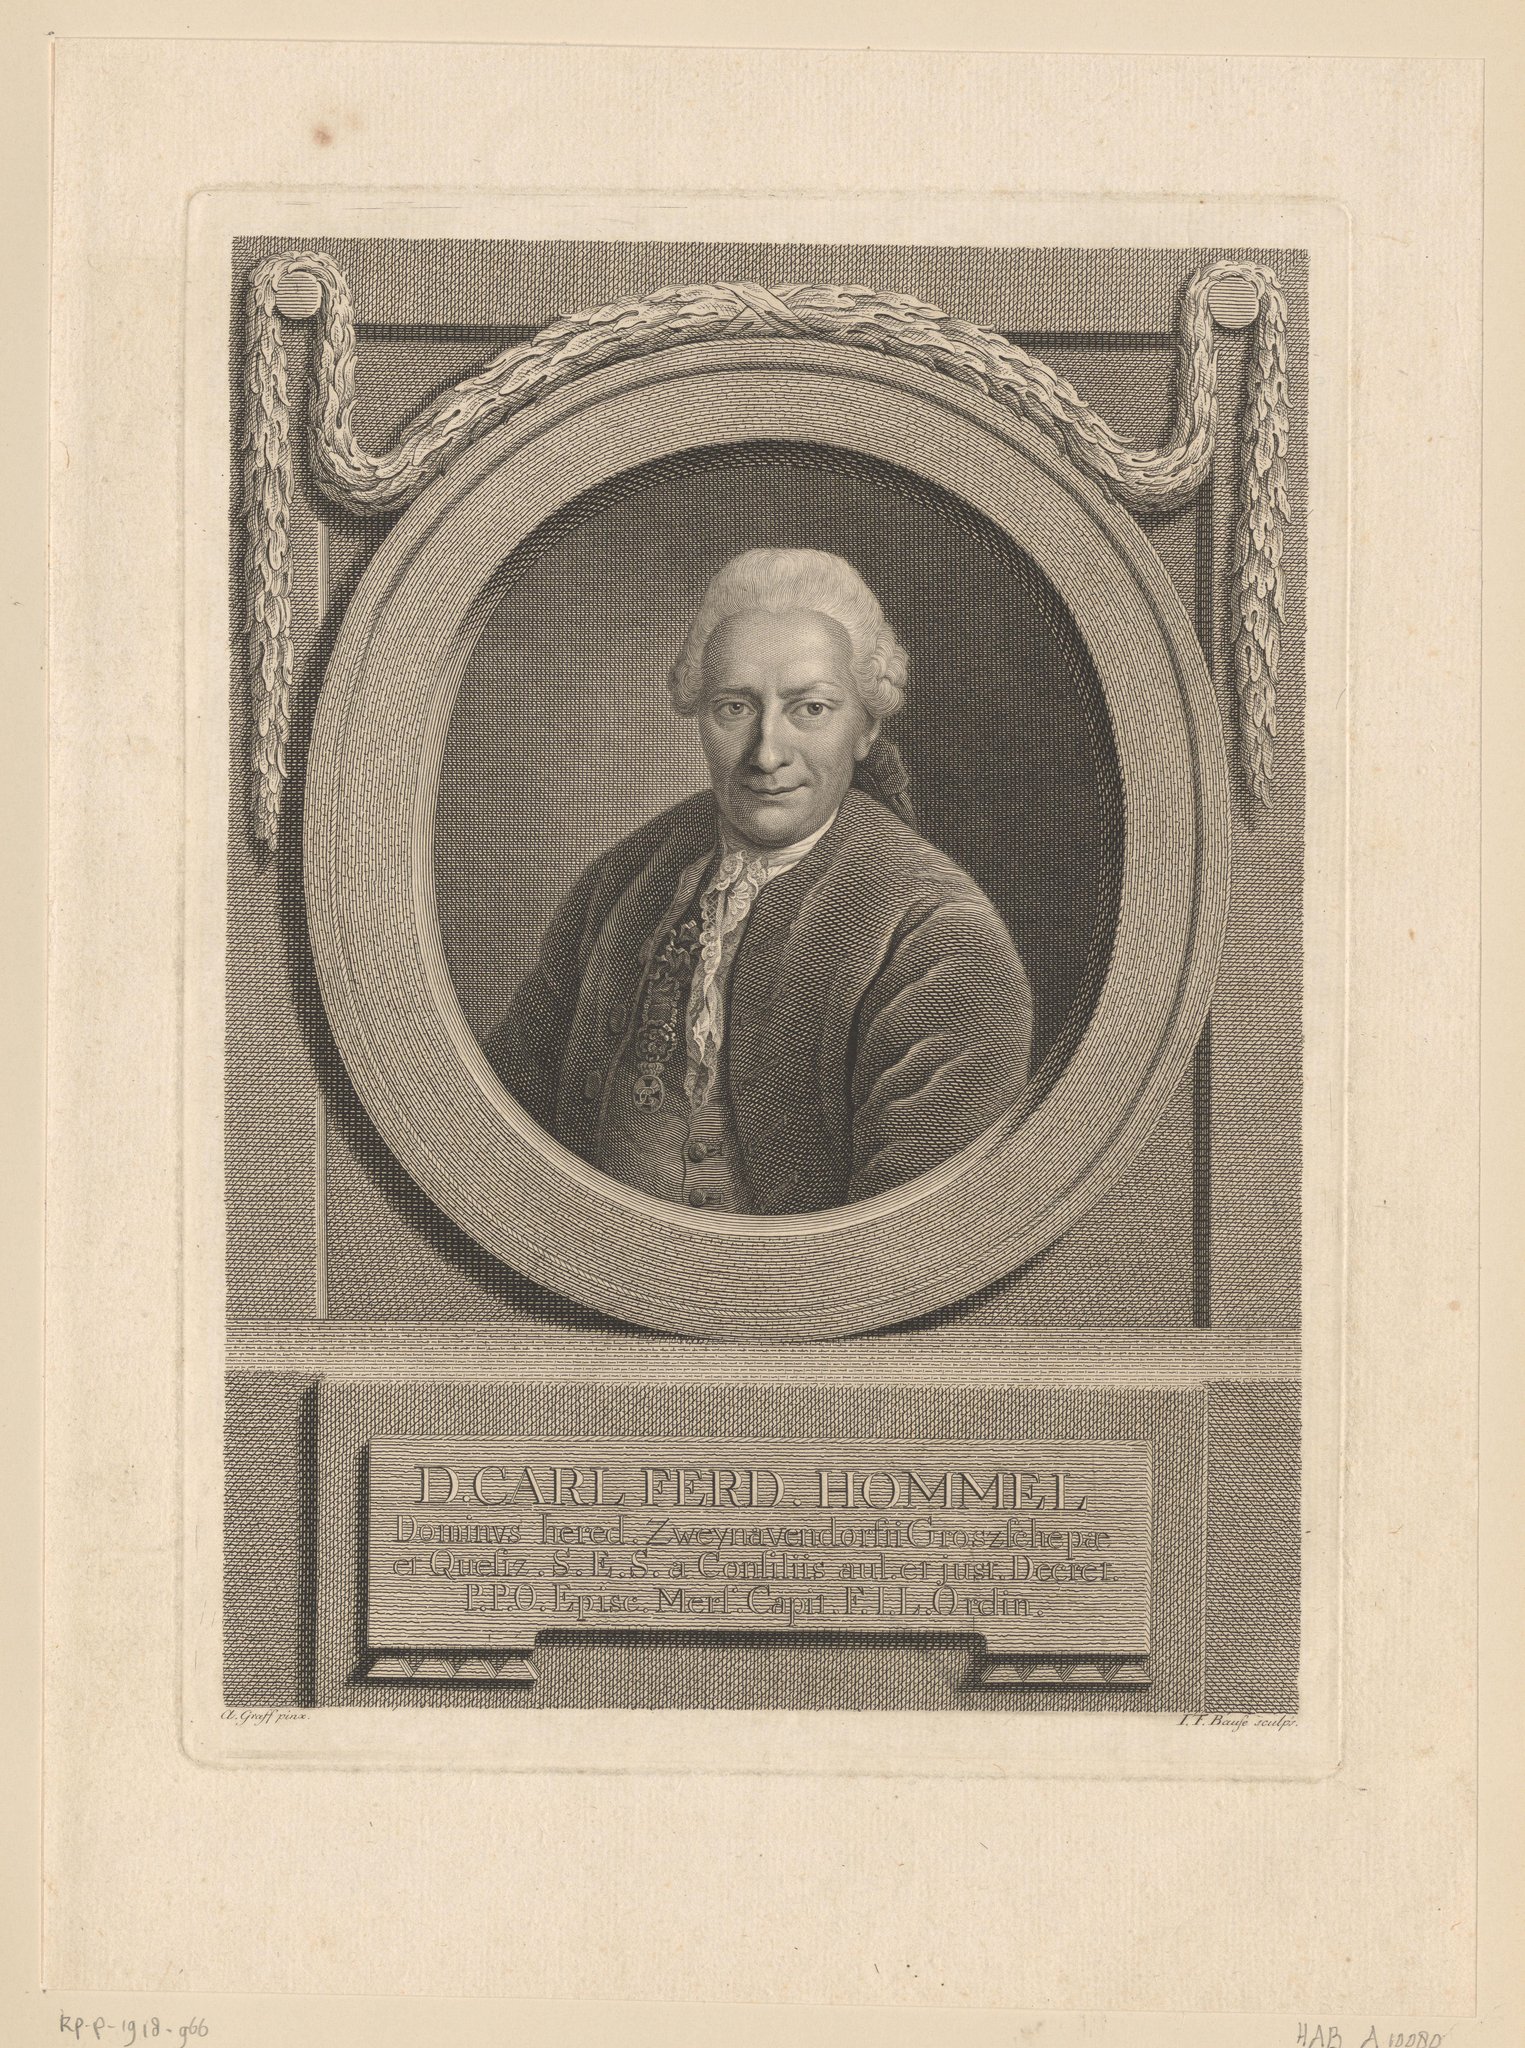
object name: print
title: Portret van Carl Ferdinand Hommel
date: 1780-1814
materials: paper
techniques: engraving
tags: adult man, historical persons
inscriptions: collector's mark: Lugt 2233